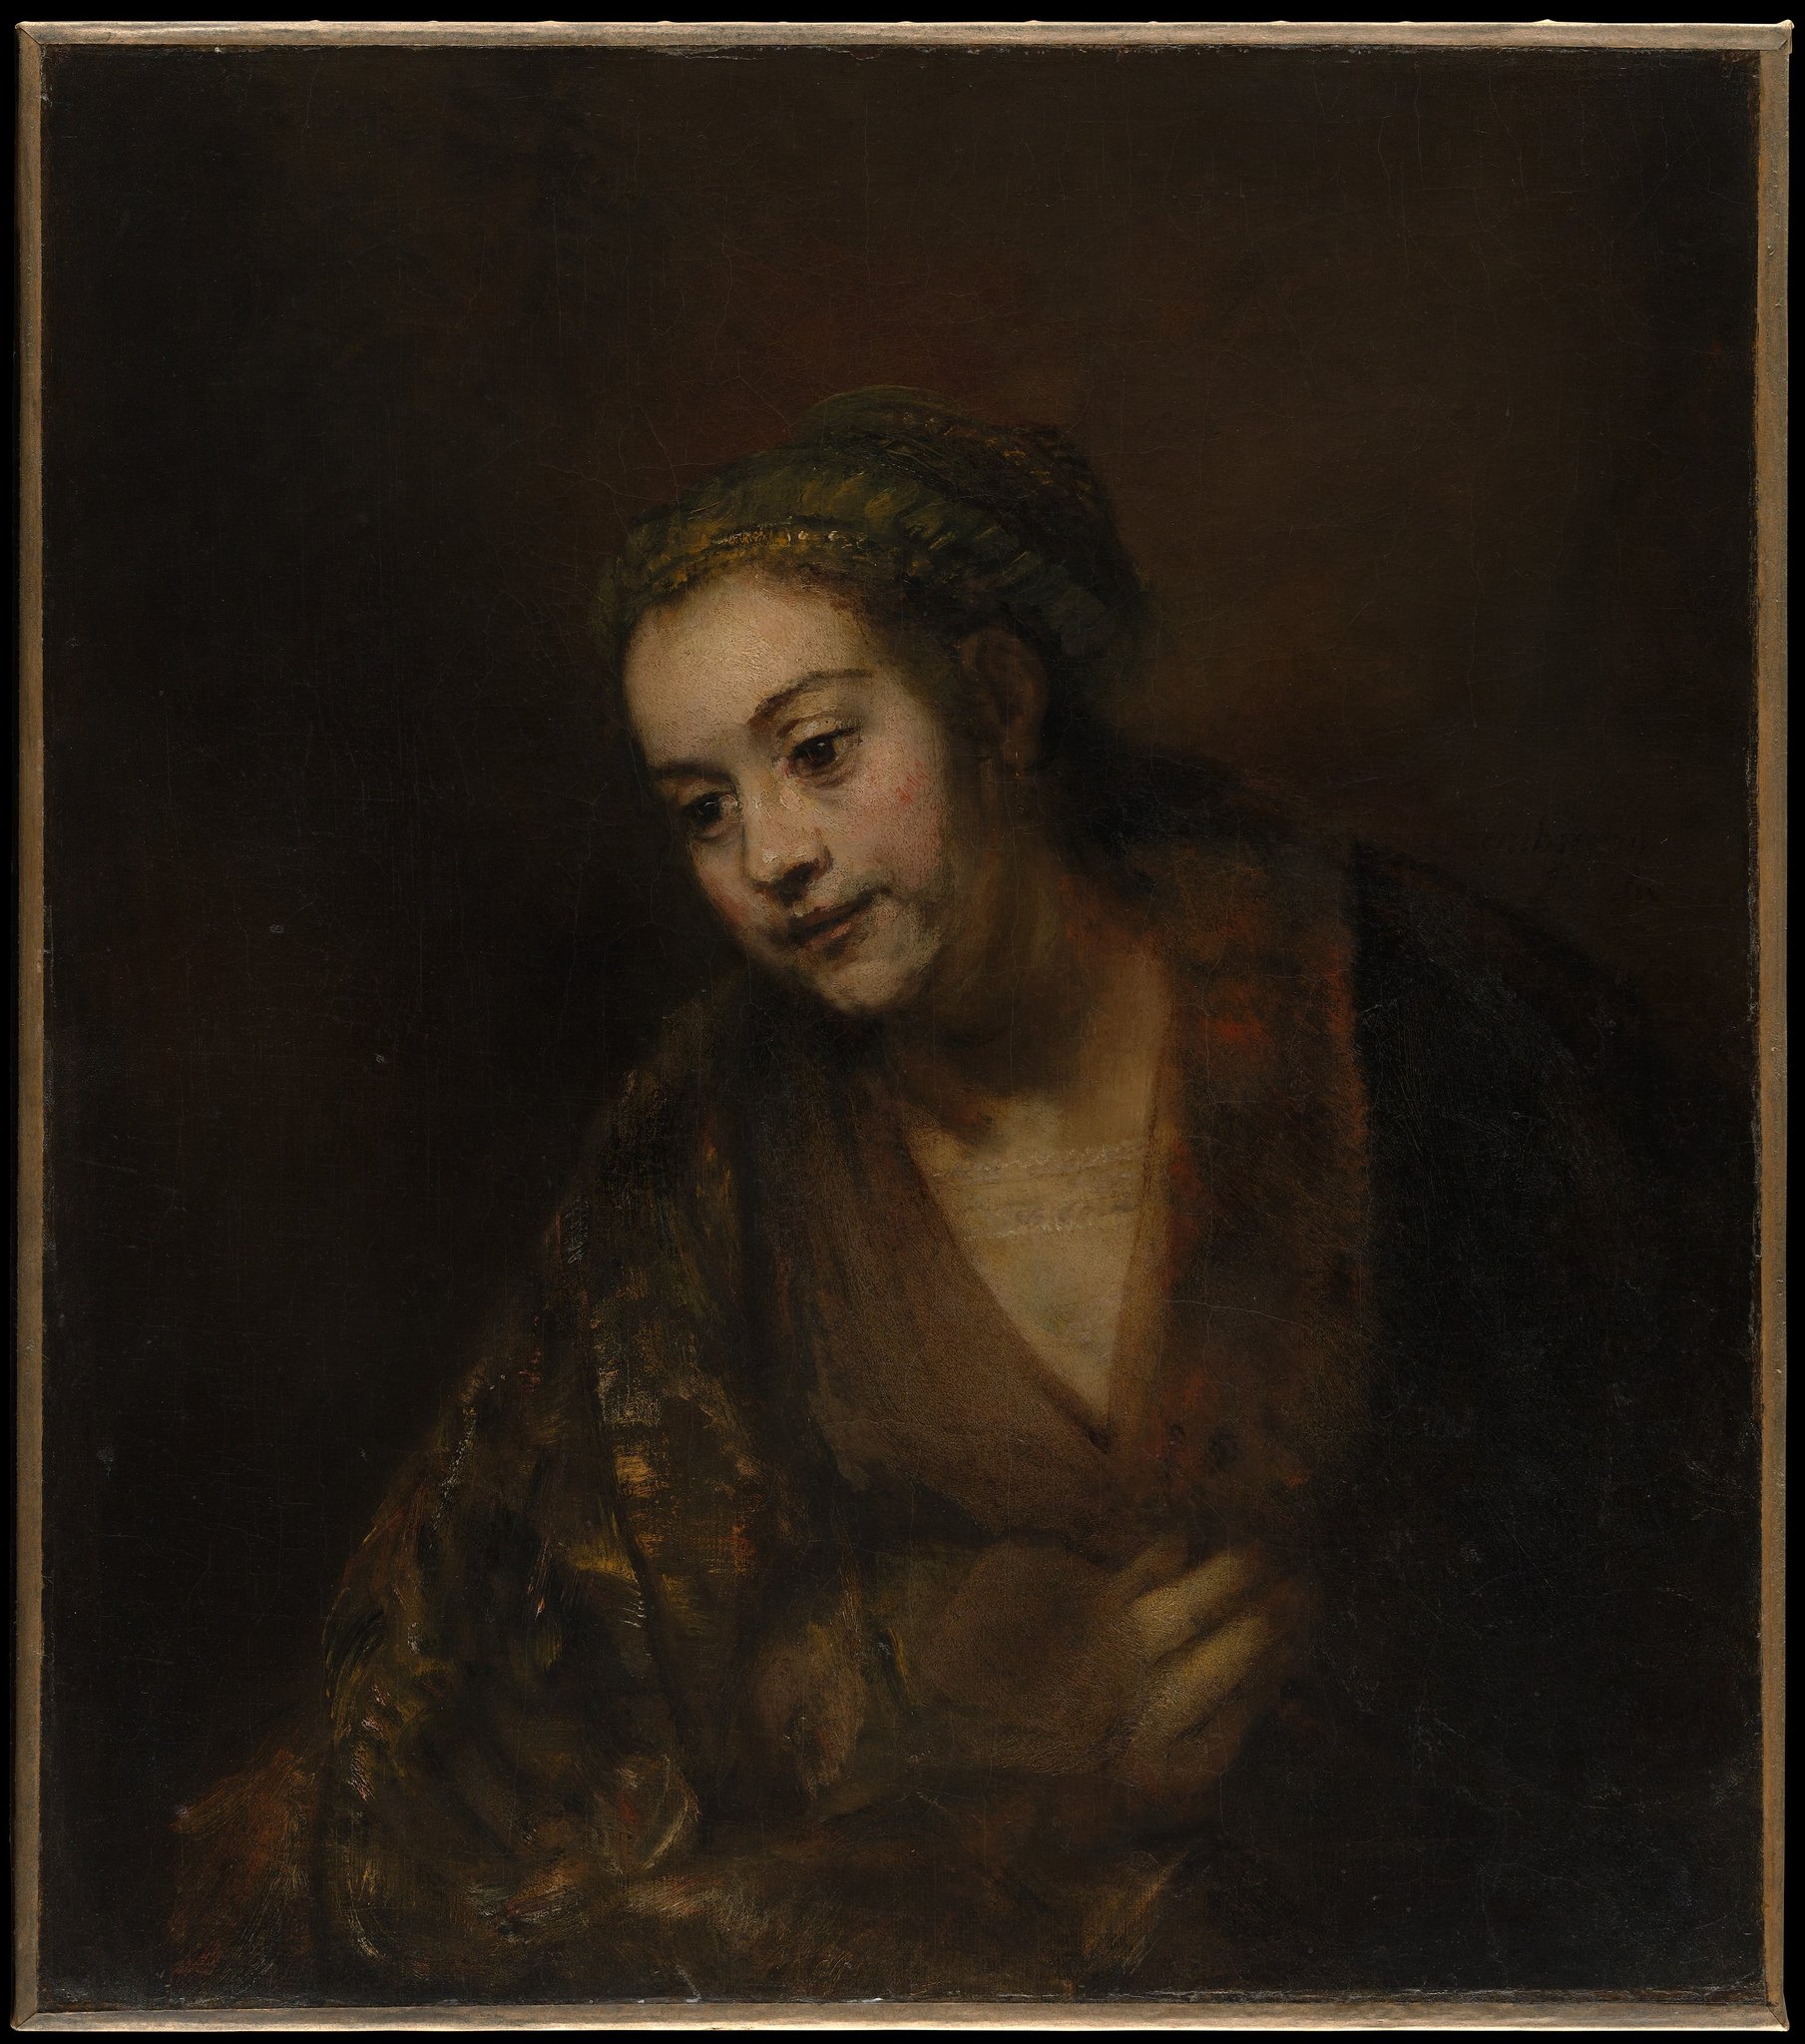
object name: painting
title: Hendrickje Stoffels (1626–1663)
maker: rembrandt van rijn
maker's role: artist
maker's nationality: dutch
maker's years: 1606-1669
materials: canvas, oil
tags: portraits,women